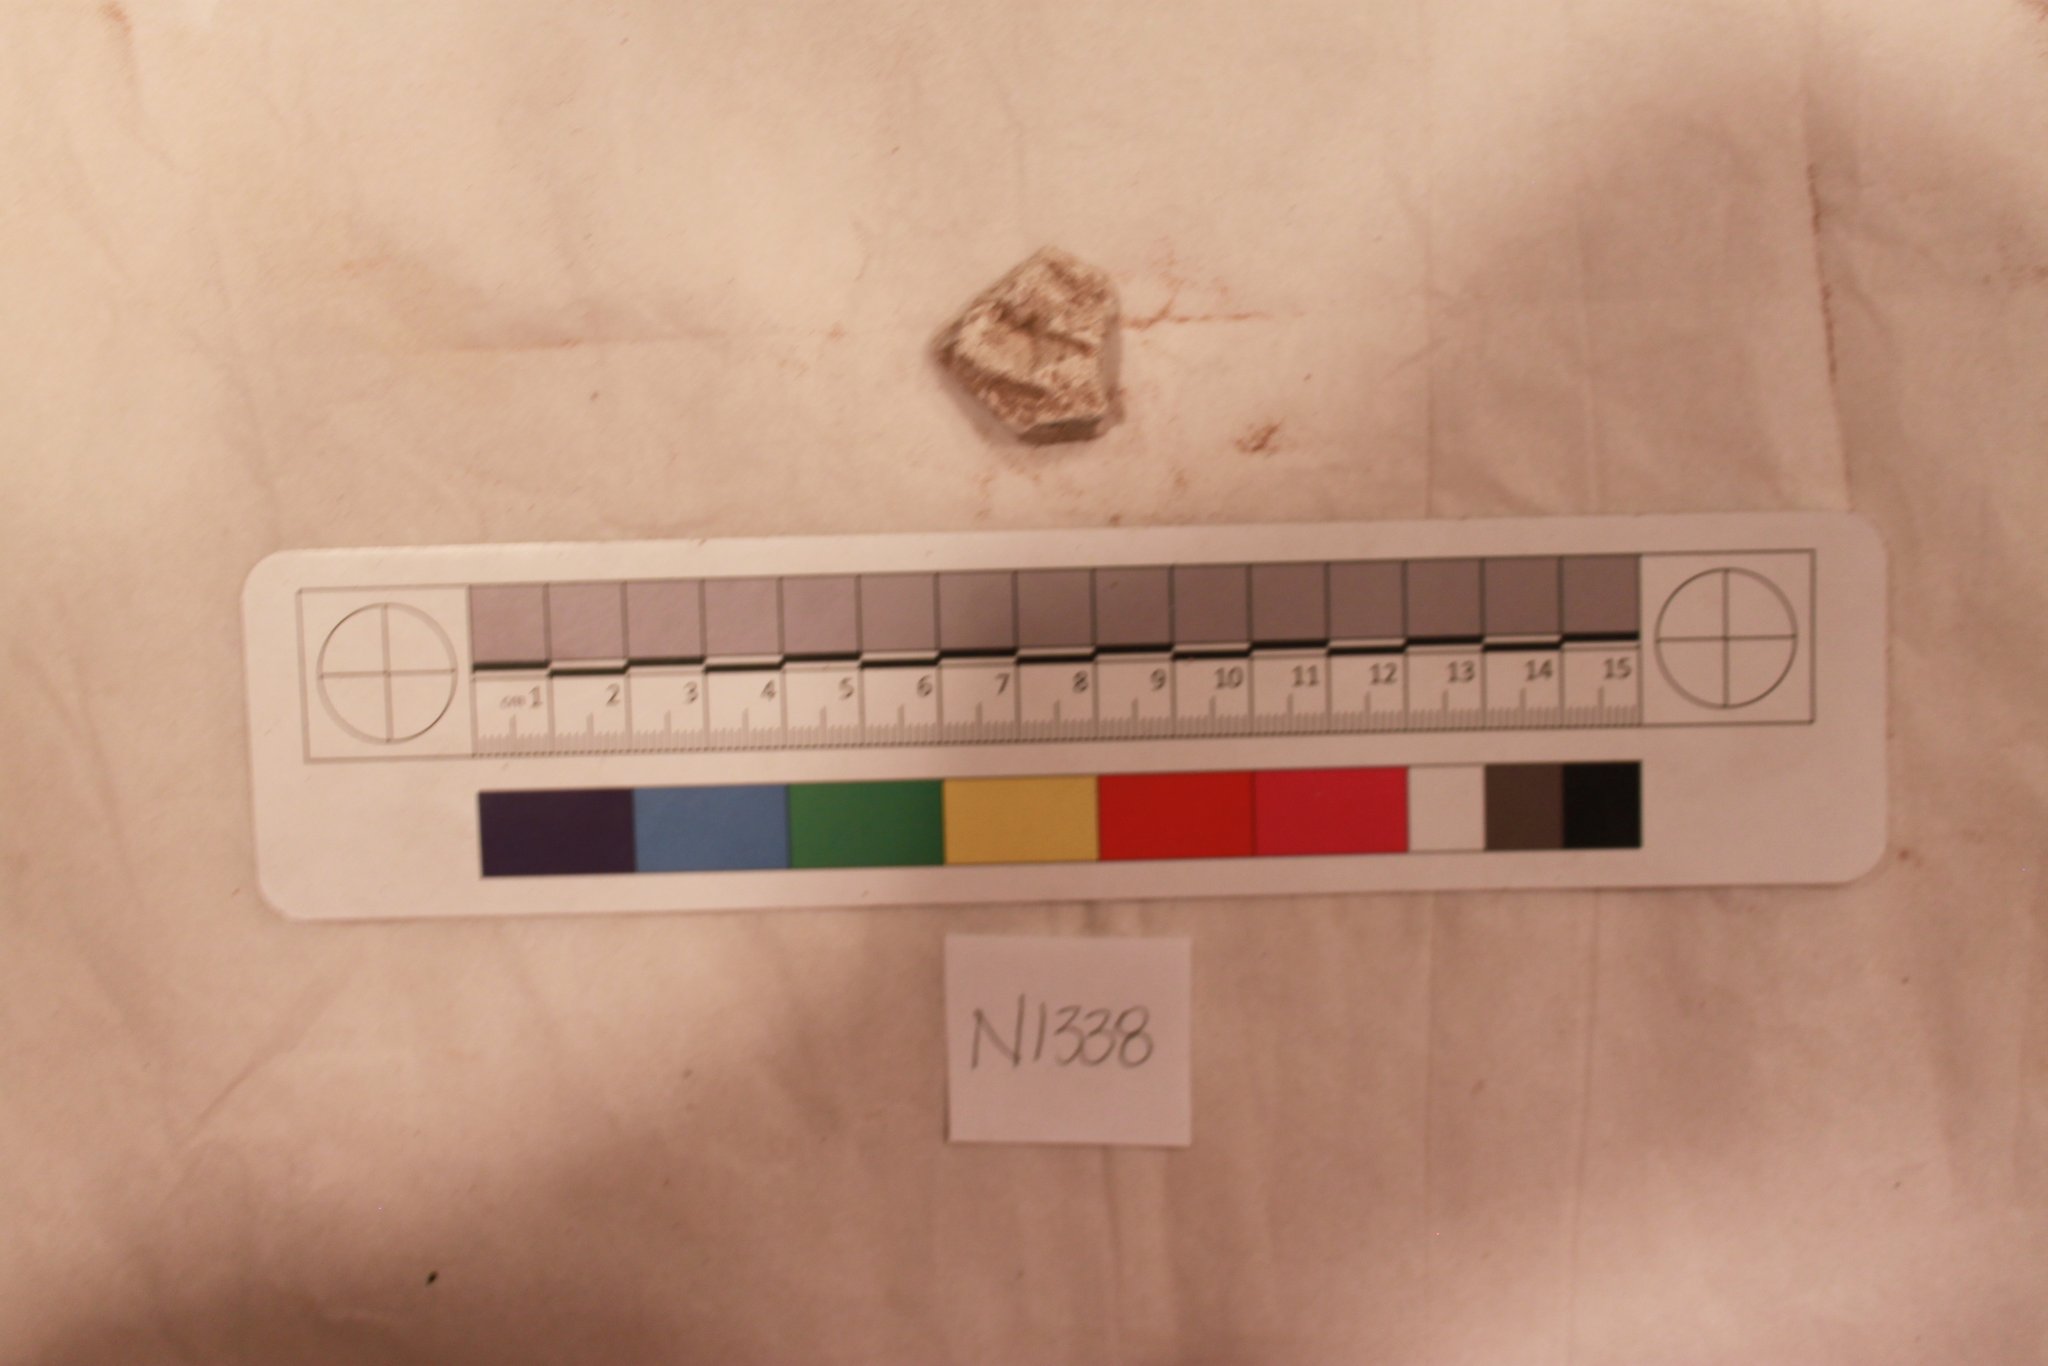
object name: fragment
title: Stucco Fragment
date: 701-1200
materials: plaster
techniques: carving, painting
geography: iran